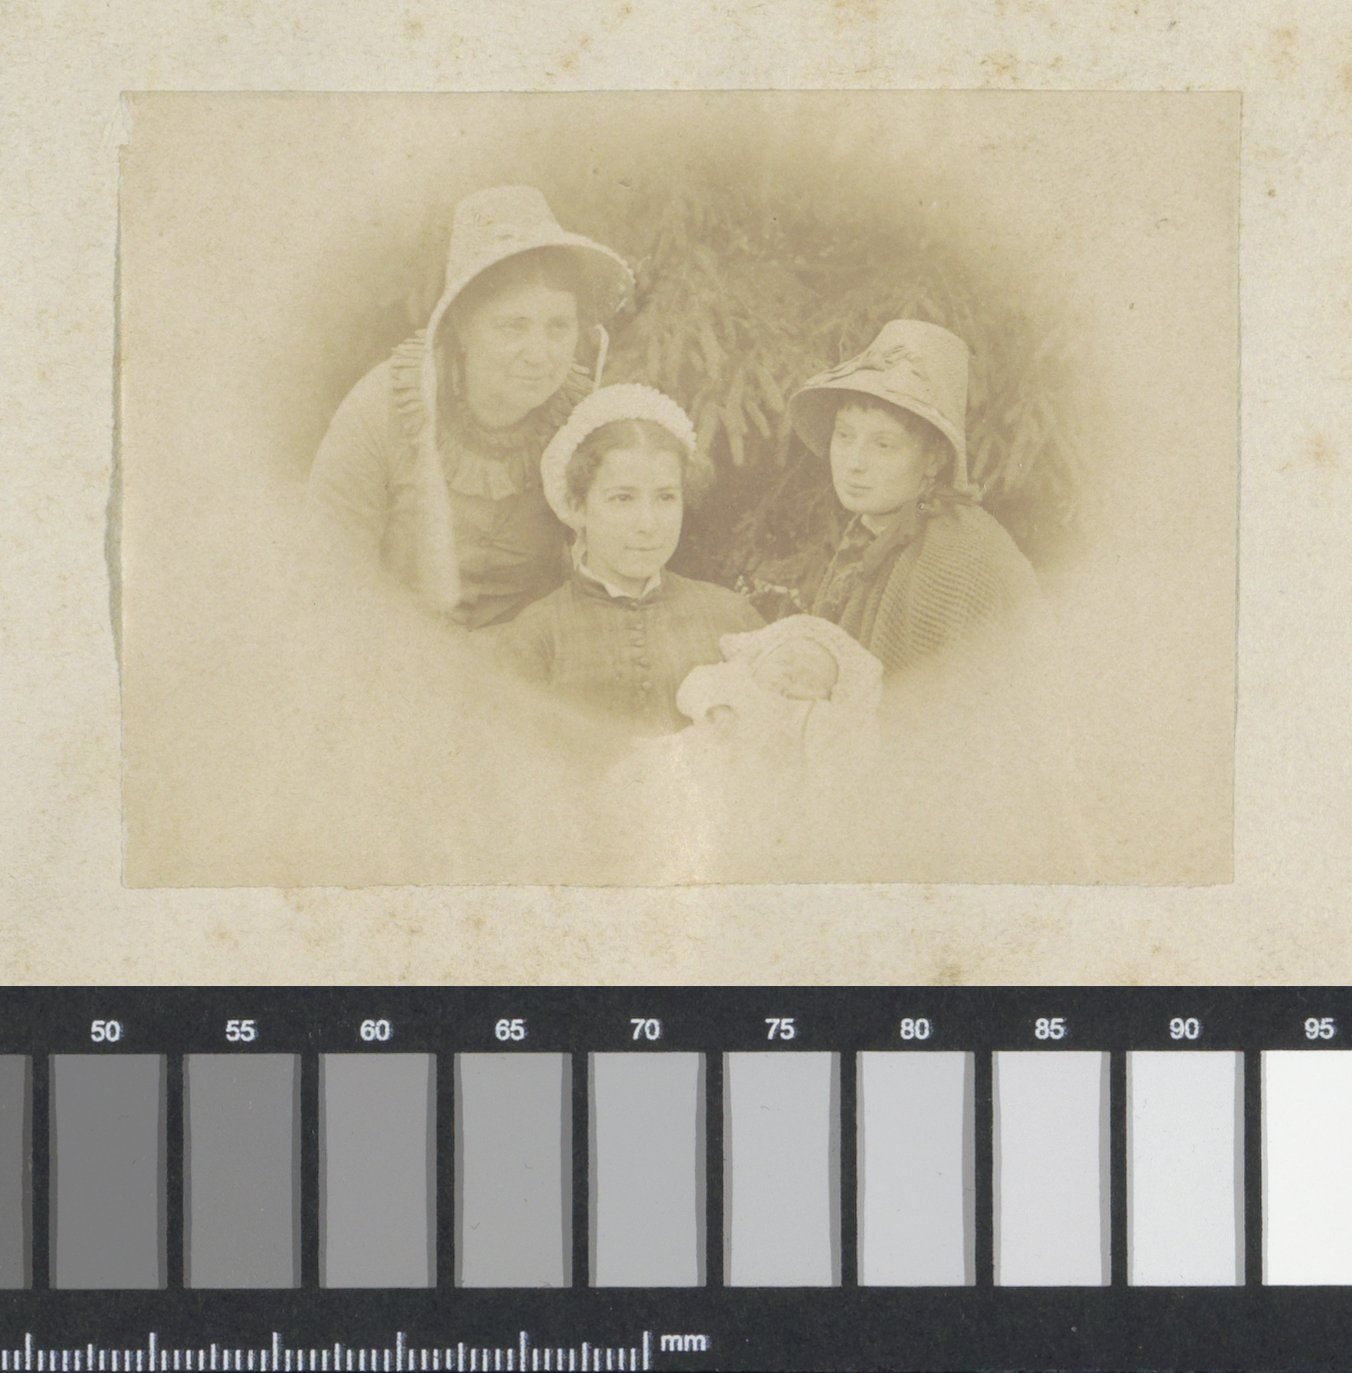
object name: photograph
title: Groepsportret van drie Françaises en een baby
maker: Anonymous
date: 1883-1886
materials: photographic support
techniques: albumen print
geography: france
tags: adult woman, mother and baby or young child, three generations (family group)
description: Onderdeel van Album van een Franse amateurfotograaf met opnames van familie, militairen, industrie, landschappen en bezienswaardigheden in Frankrijk.